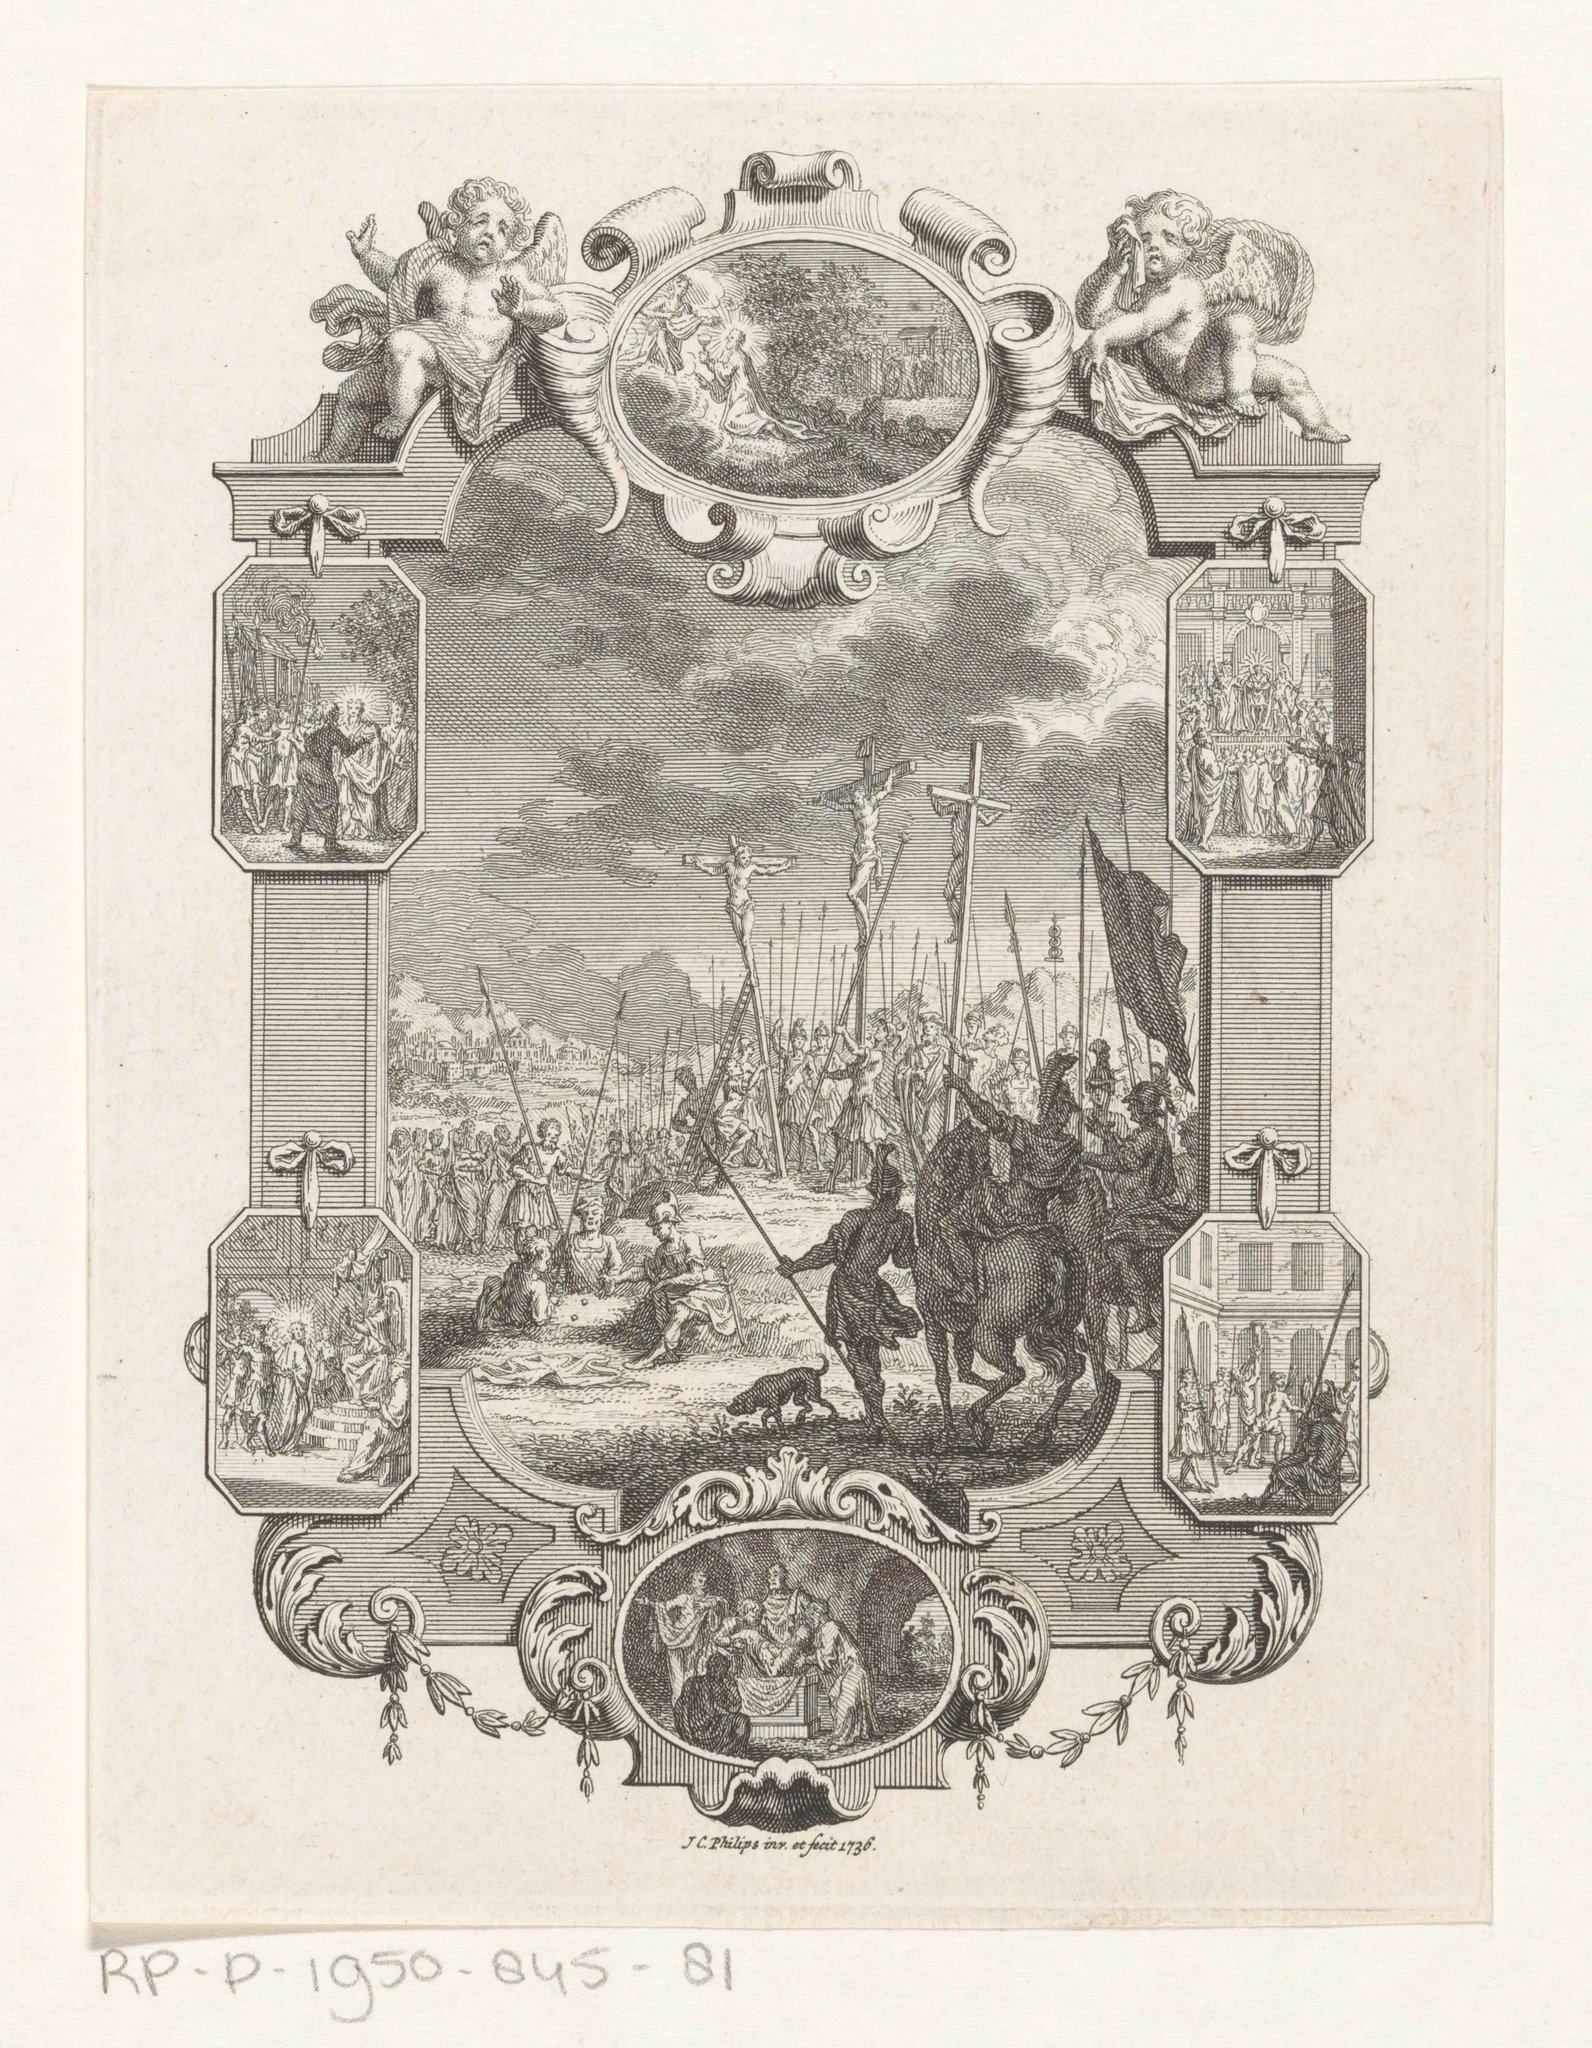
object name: book illustration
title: Cartouche met de kruisiging van Christus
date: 1736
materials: paper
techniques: engraving, etching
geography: amsterdam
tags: the crucifixion of christ: christ's death on the cross; golgotha (matthew 27:45-58; mark 15:33-45; luke 23:44-52; john 19:25-38), passion of christ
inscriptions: collector's mark: Lugt 2228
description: Prent uit: Kramer, Adriaan de. Alle de werken. Amsterdam: Sligtenhorst, Hendrik, 1736. Prent afkomstig uit een plakalbum met titelprenten, ornamenten etc. op blauw papier in 1983 uit elkaar gehaald. Volgens een notitie op verso zat de prent op p. 81 van dit album.